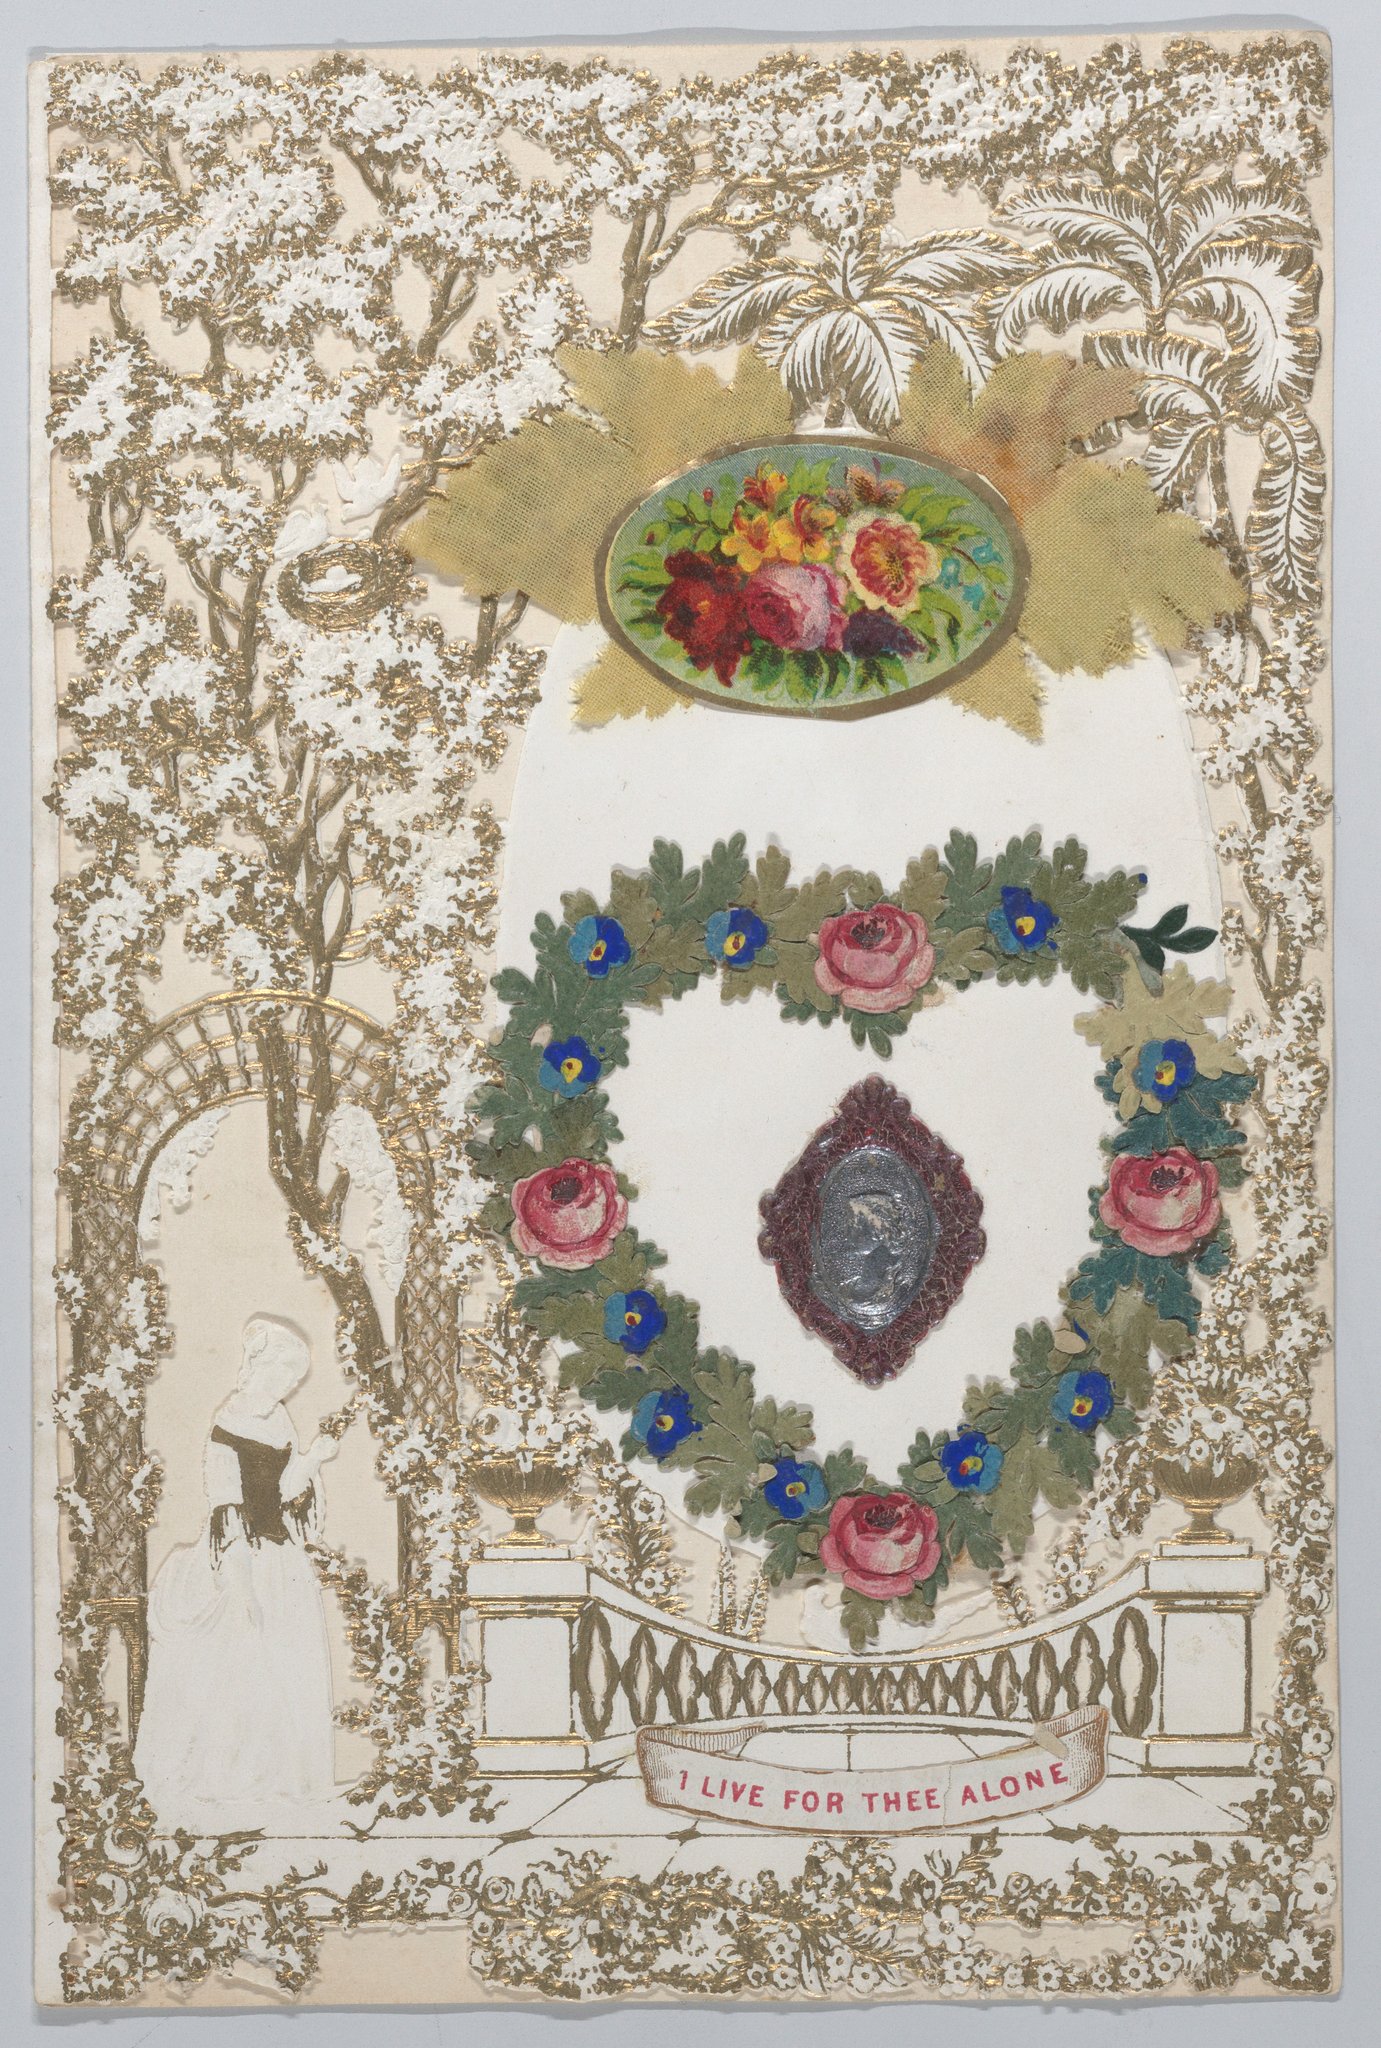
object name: valentine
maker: Anonymous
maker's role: artist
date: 1850-1860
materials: paper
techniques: cutting, embossing, gilding